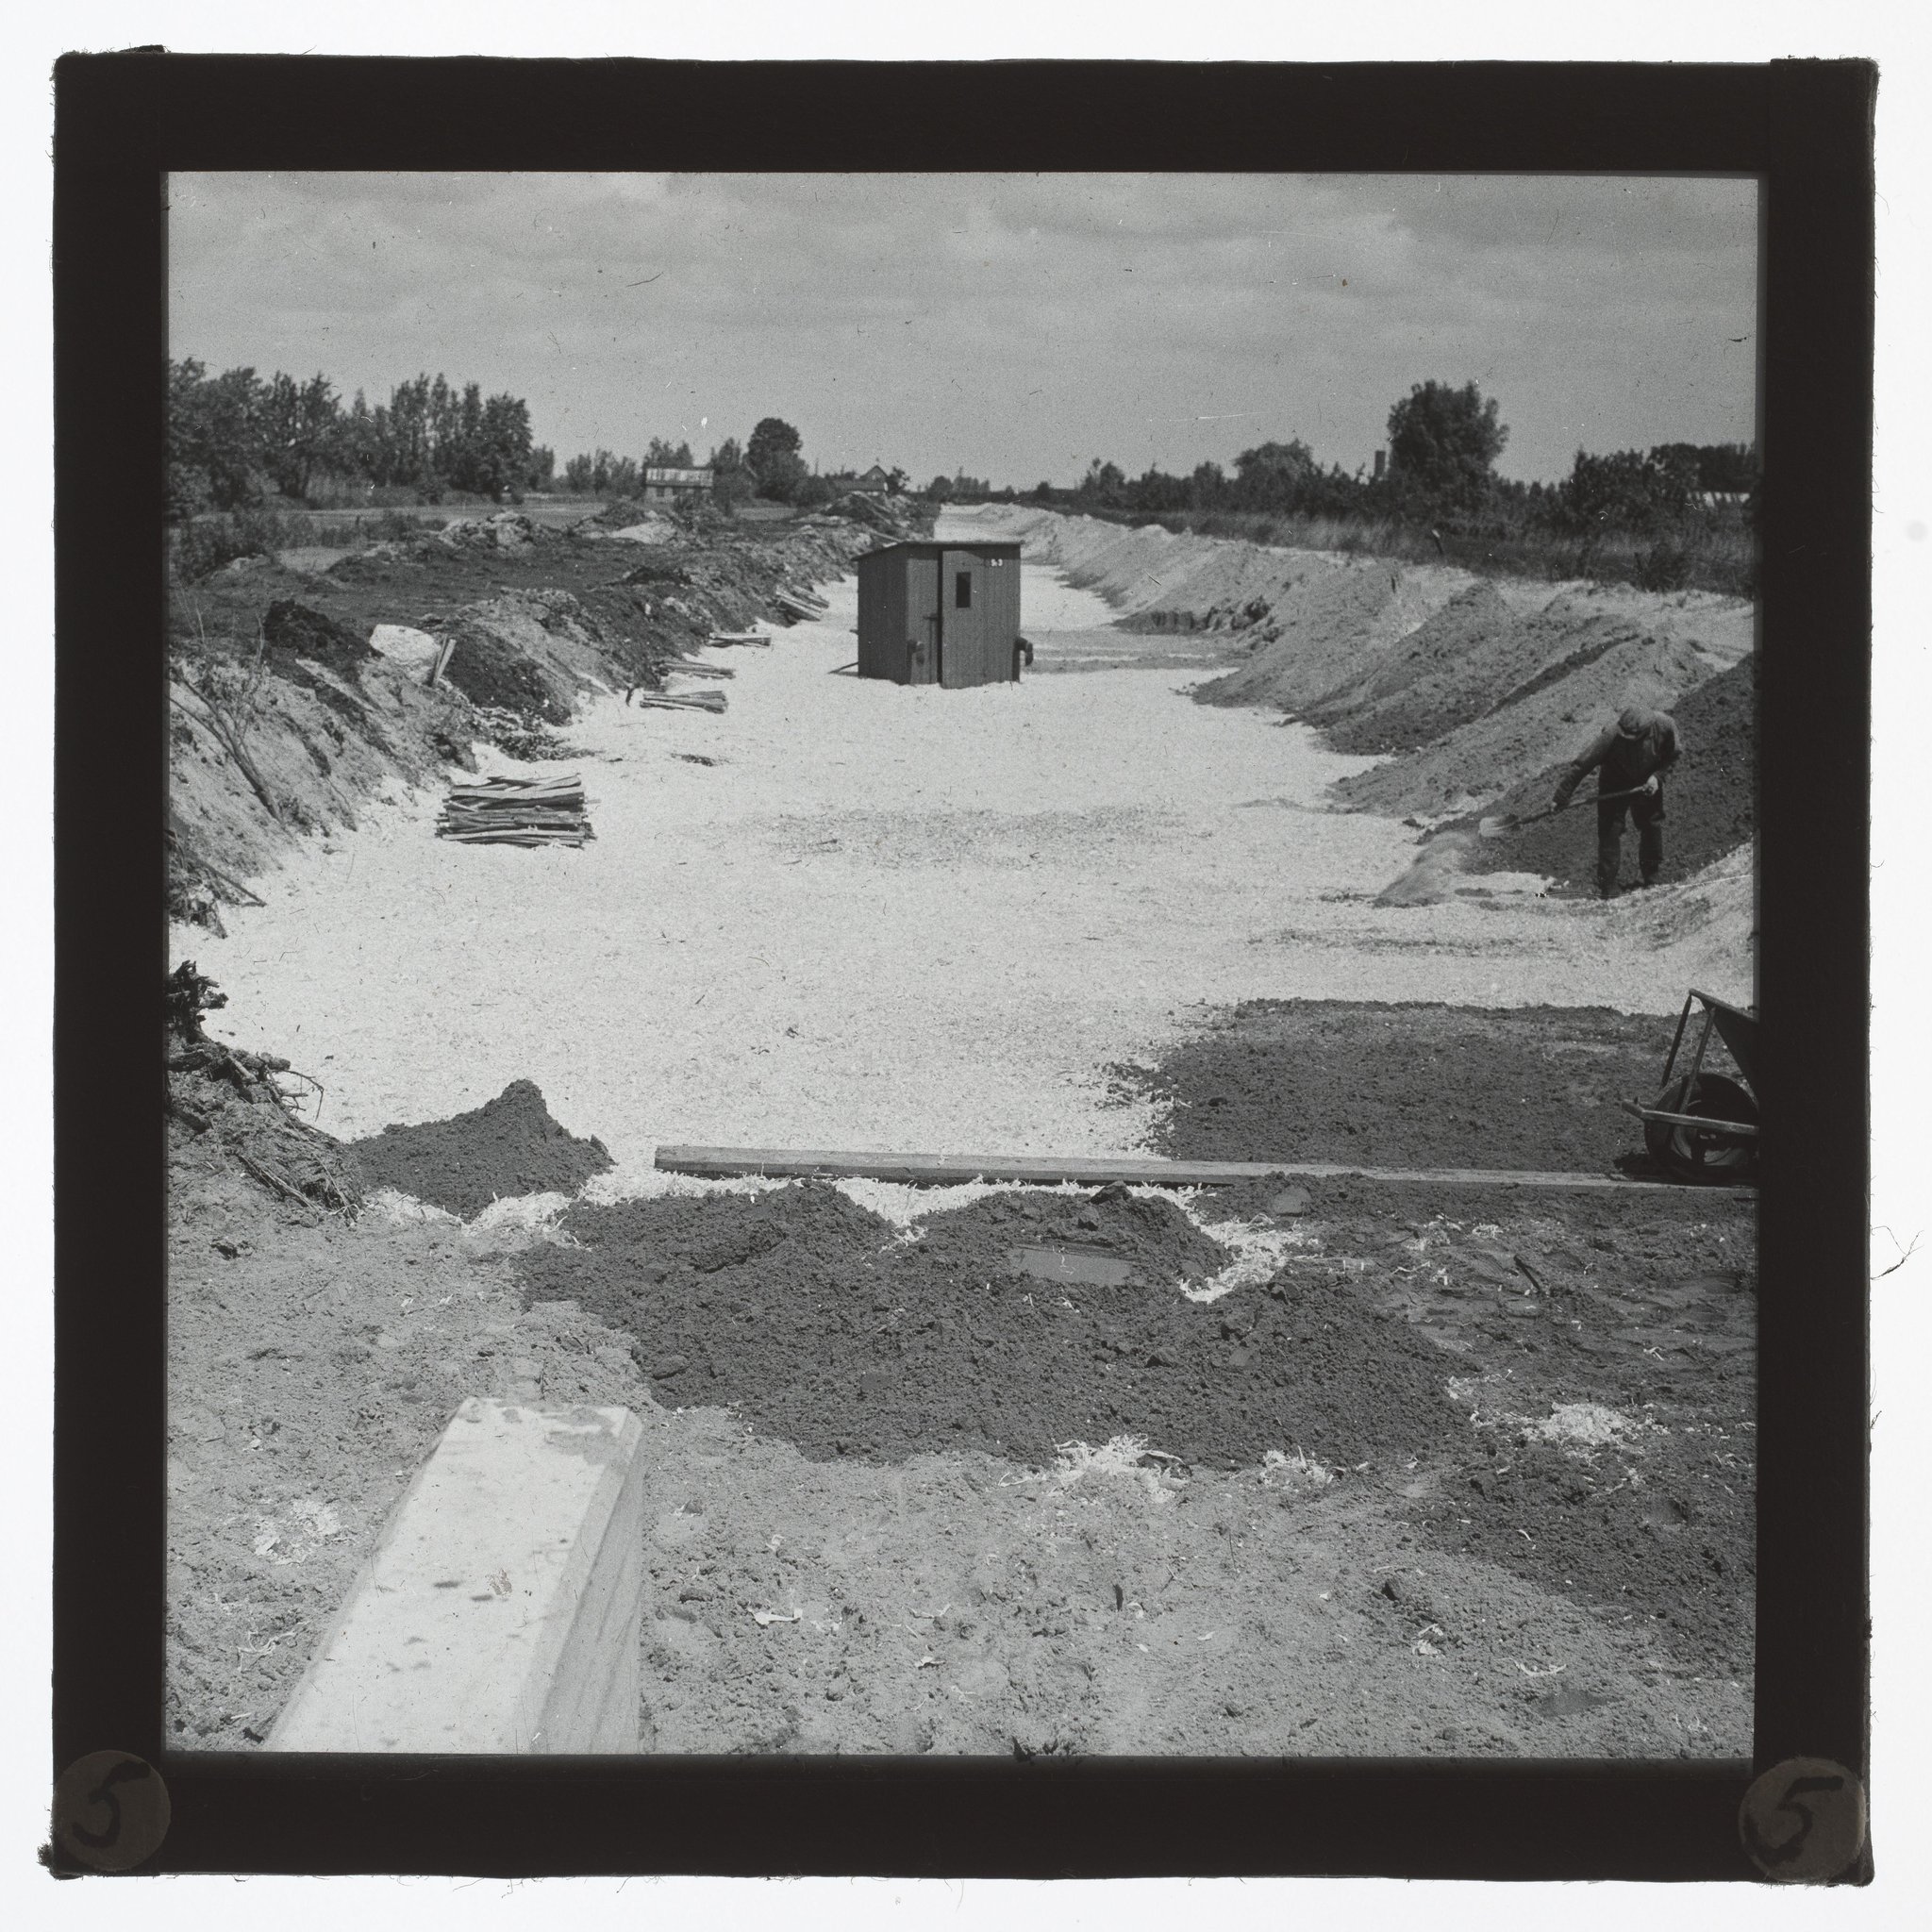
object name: lantern slide photographic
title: Weg in aanbouw, Zuid-Holland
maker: Anonymous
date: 1956-1960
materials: glass, paper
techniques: gelatin silver transparency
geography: south holland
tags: laying the foundations; trench, public road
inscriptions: number: ‘5’